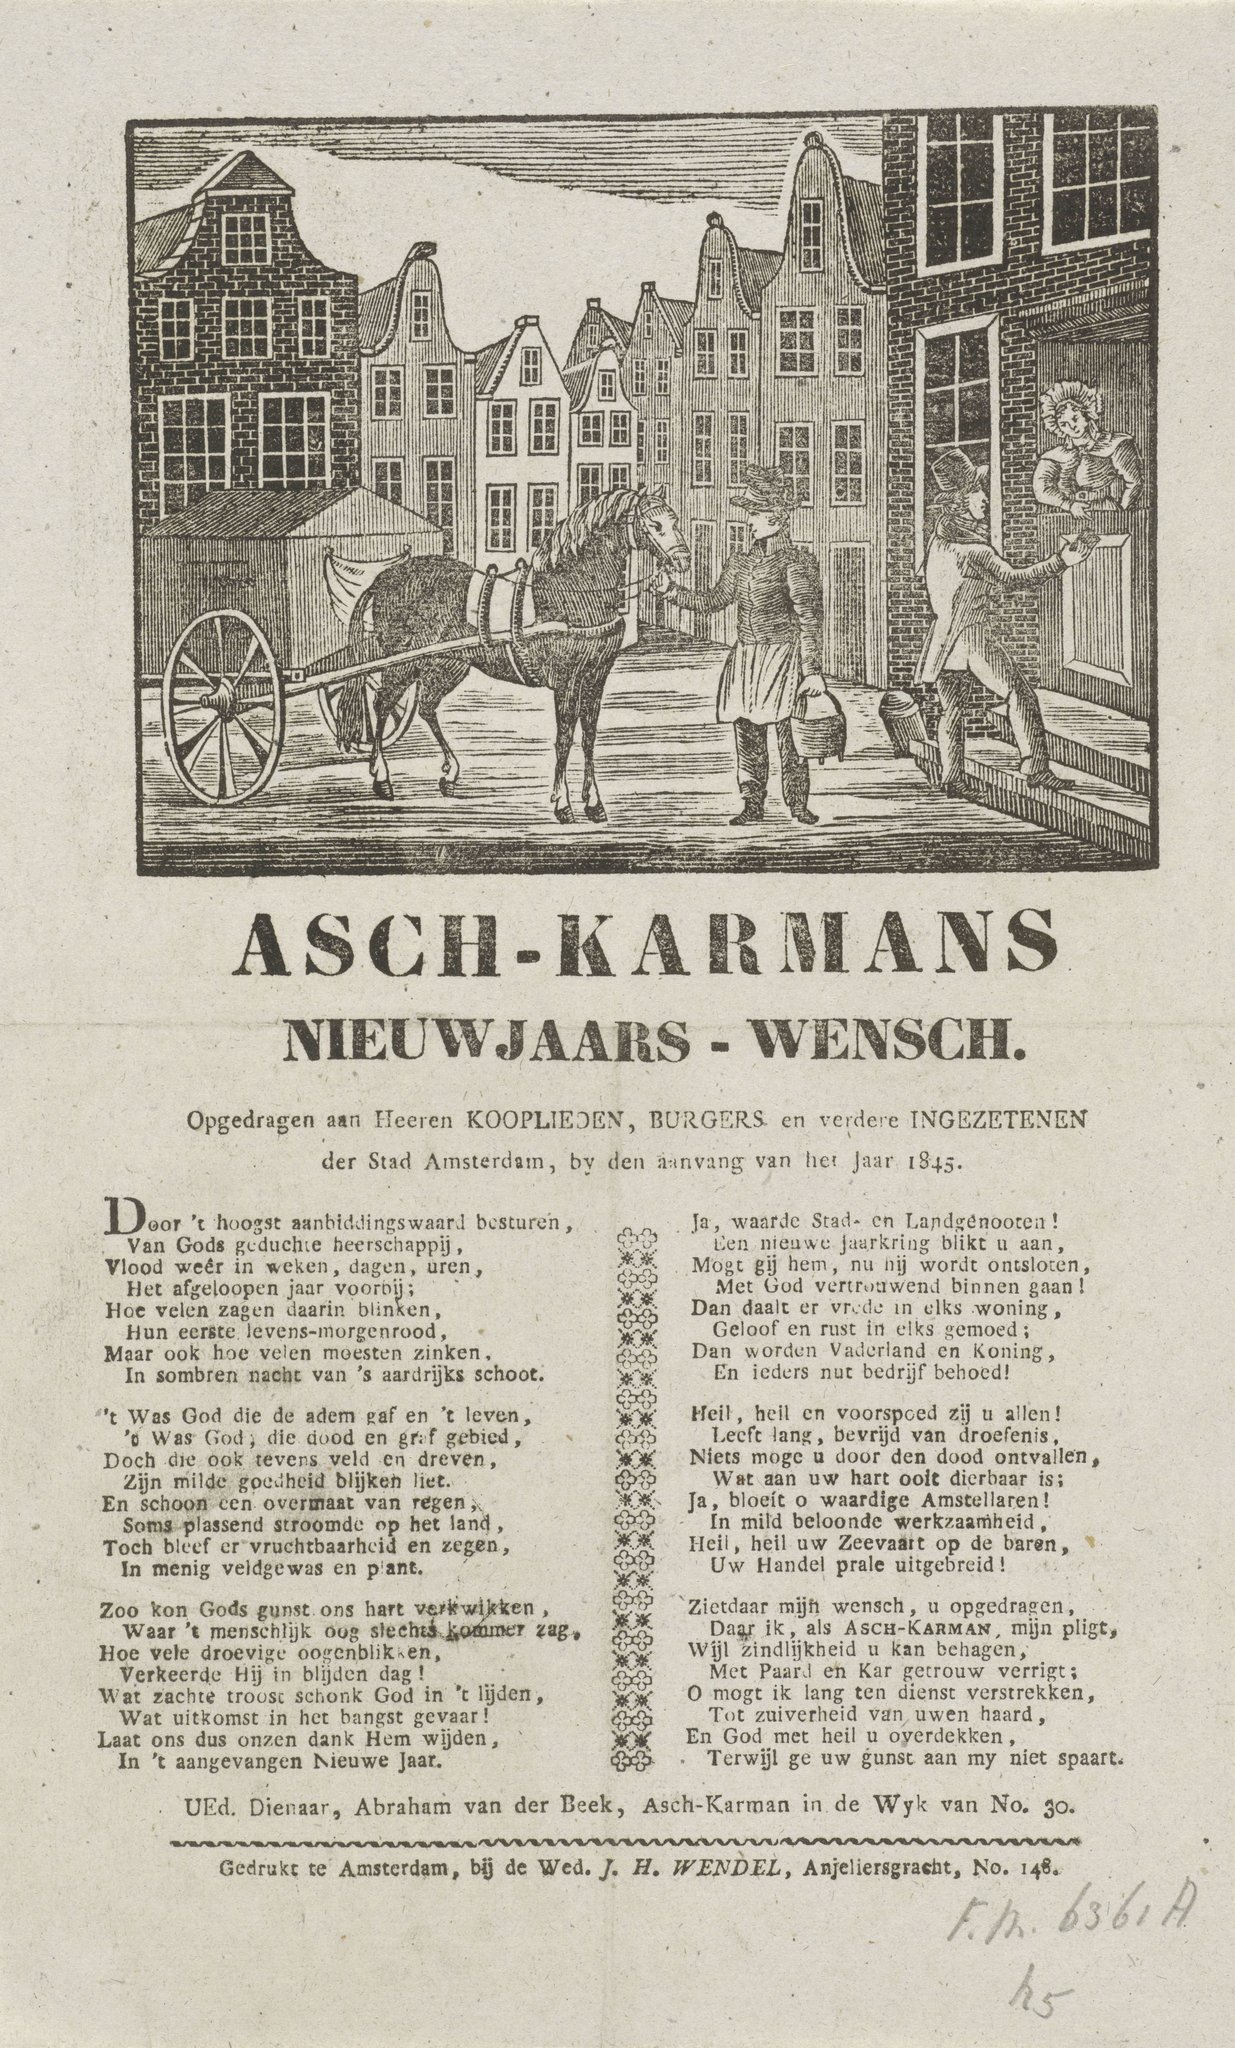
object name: new year card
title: Asch-Karmans Nieuwjaars-Wensch (...) 1845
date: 1844-1845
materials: paper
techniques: letterpress printing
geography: amsterdam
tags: public road - ii - ideal city, garbage collection, amsterdam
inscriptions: collector's mark: Lugt 2228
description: Nieuwjaarswens namens de askarrenmannen (karrenman of vuilnisman) te Amsterdam voor het jaar 1845. Gezicht in een straat te Amsterdam met een man staande met een asemmer bij de kar terwijl een andere man aan huis geld ophaalt. Onderaan een gedicht in twee kolommen. Namens Abraham van der Beek, de askarreman van wijk no. 30.